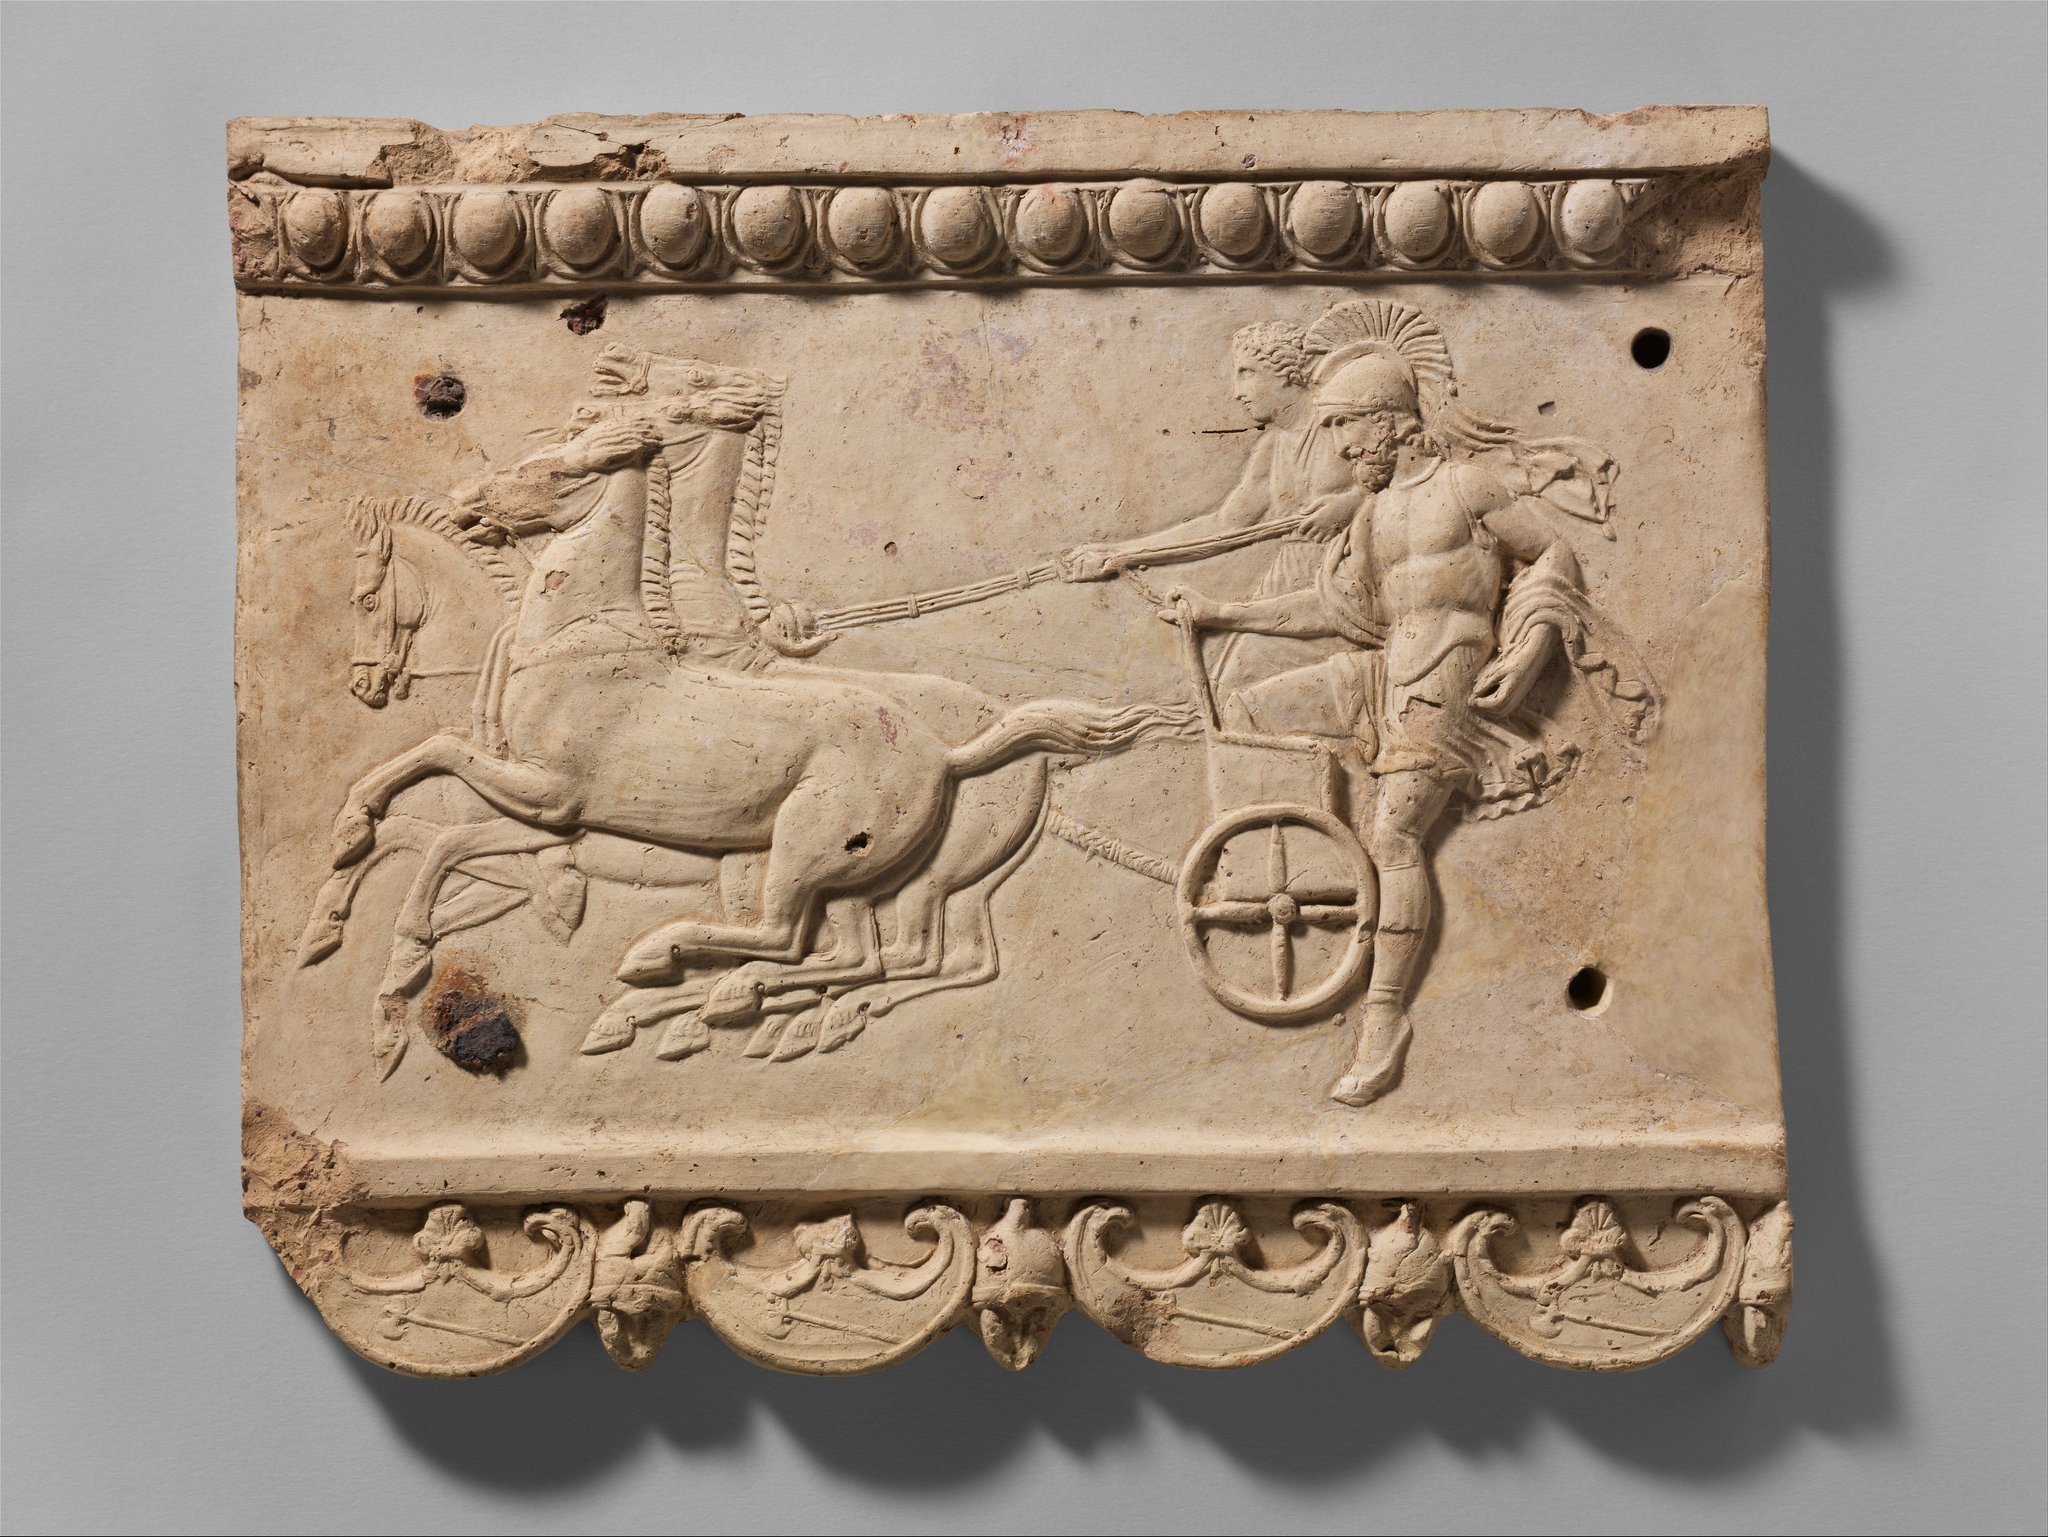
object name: relief of king oinomaos and his charioteer myrtilos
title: Terracotta plaque with King Oinomaos and his charioteer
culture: roman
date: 27 BCE-68 CE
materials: terracotta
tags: men,horses,chariots